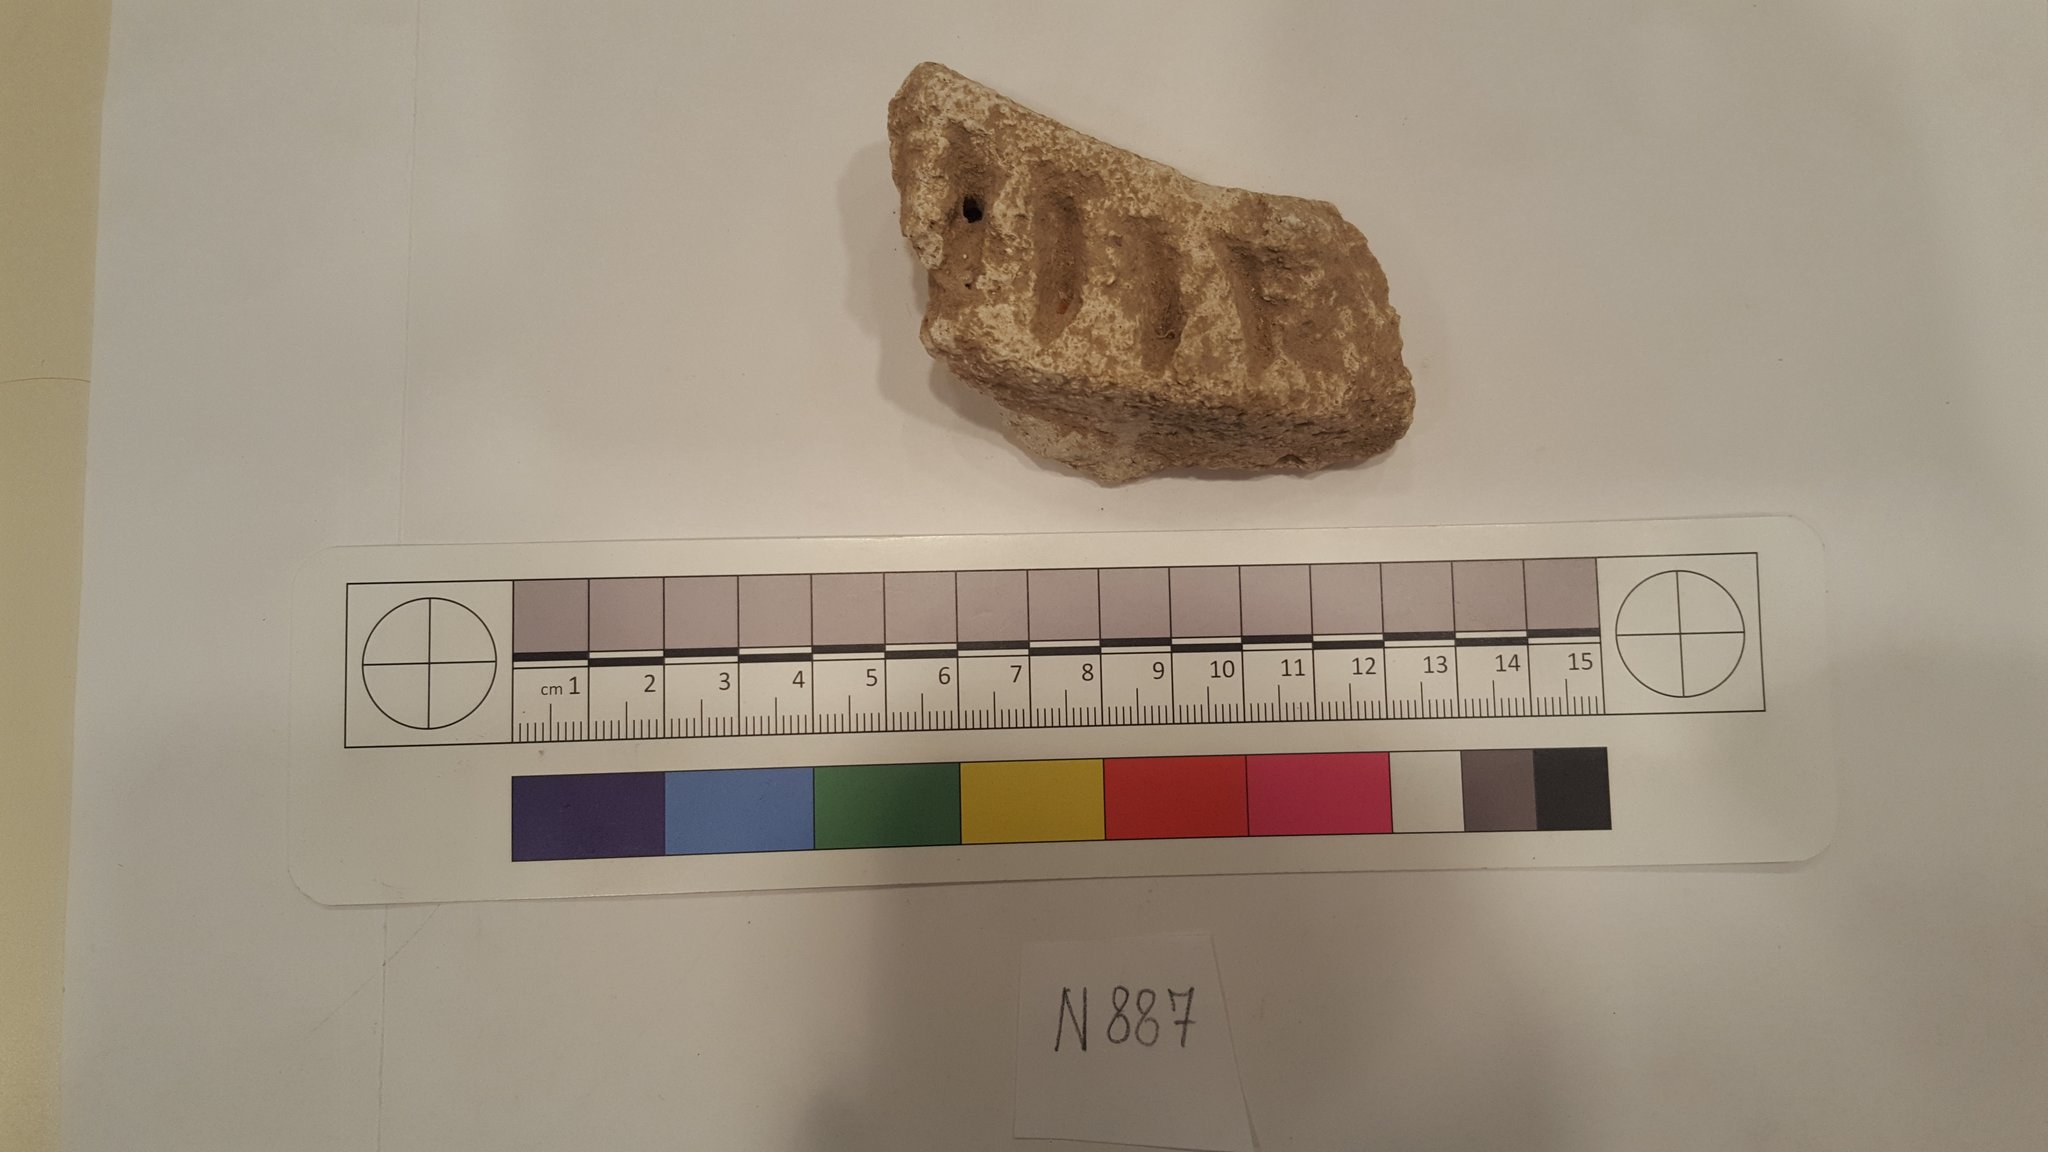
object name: fragment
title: Stucco Fragment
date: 701-1200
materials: plaster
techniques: carving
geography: iran